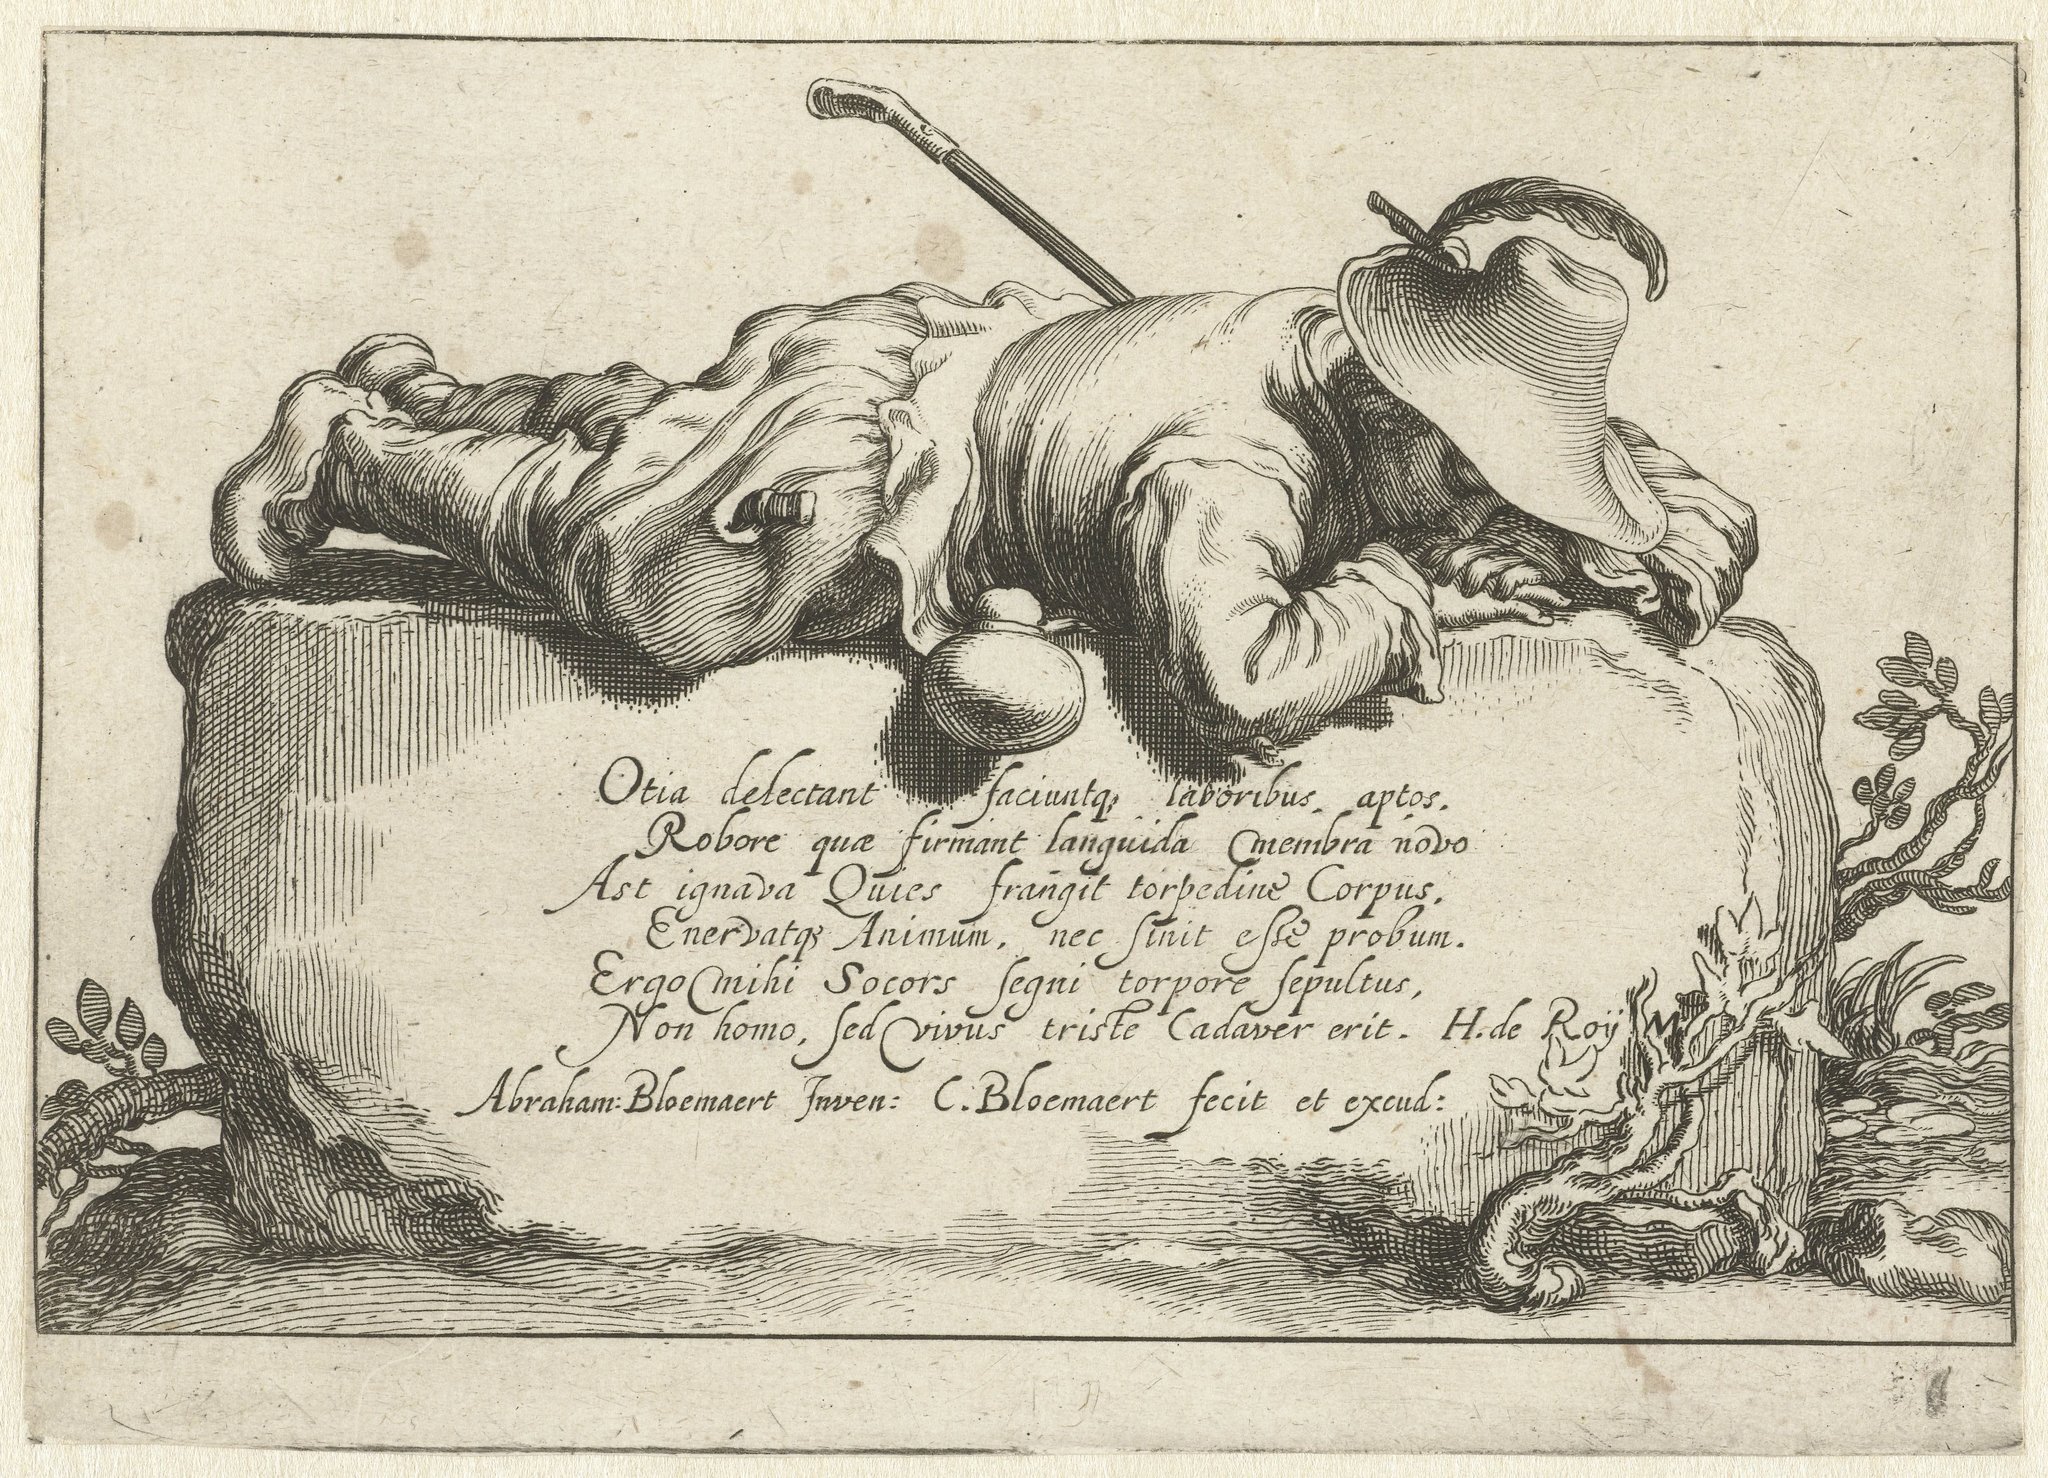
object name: titelprent, frontispice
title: Otia delectant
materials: paper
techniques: engraving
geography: utrecht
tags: pastorals, arcadian scenes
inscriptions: collector's mark: Lugt 240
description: Een man rust uit op een steen. Op de steen een zesregelig Latijns vers van Hendrik de Roij over luiheid en vrije tijd.